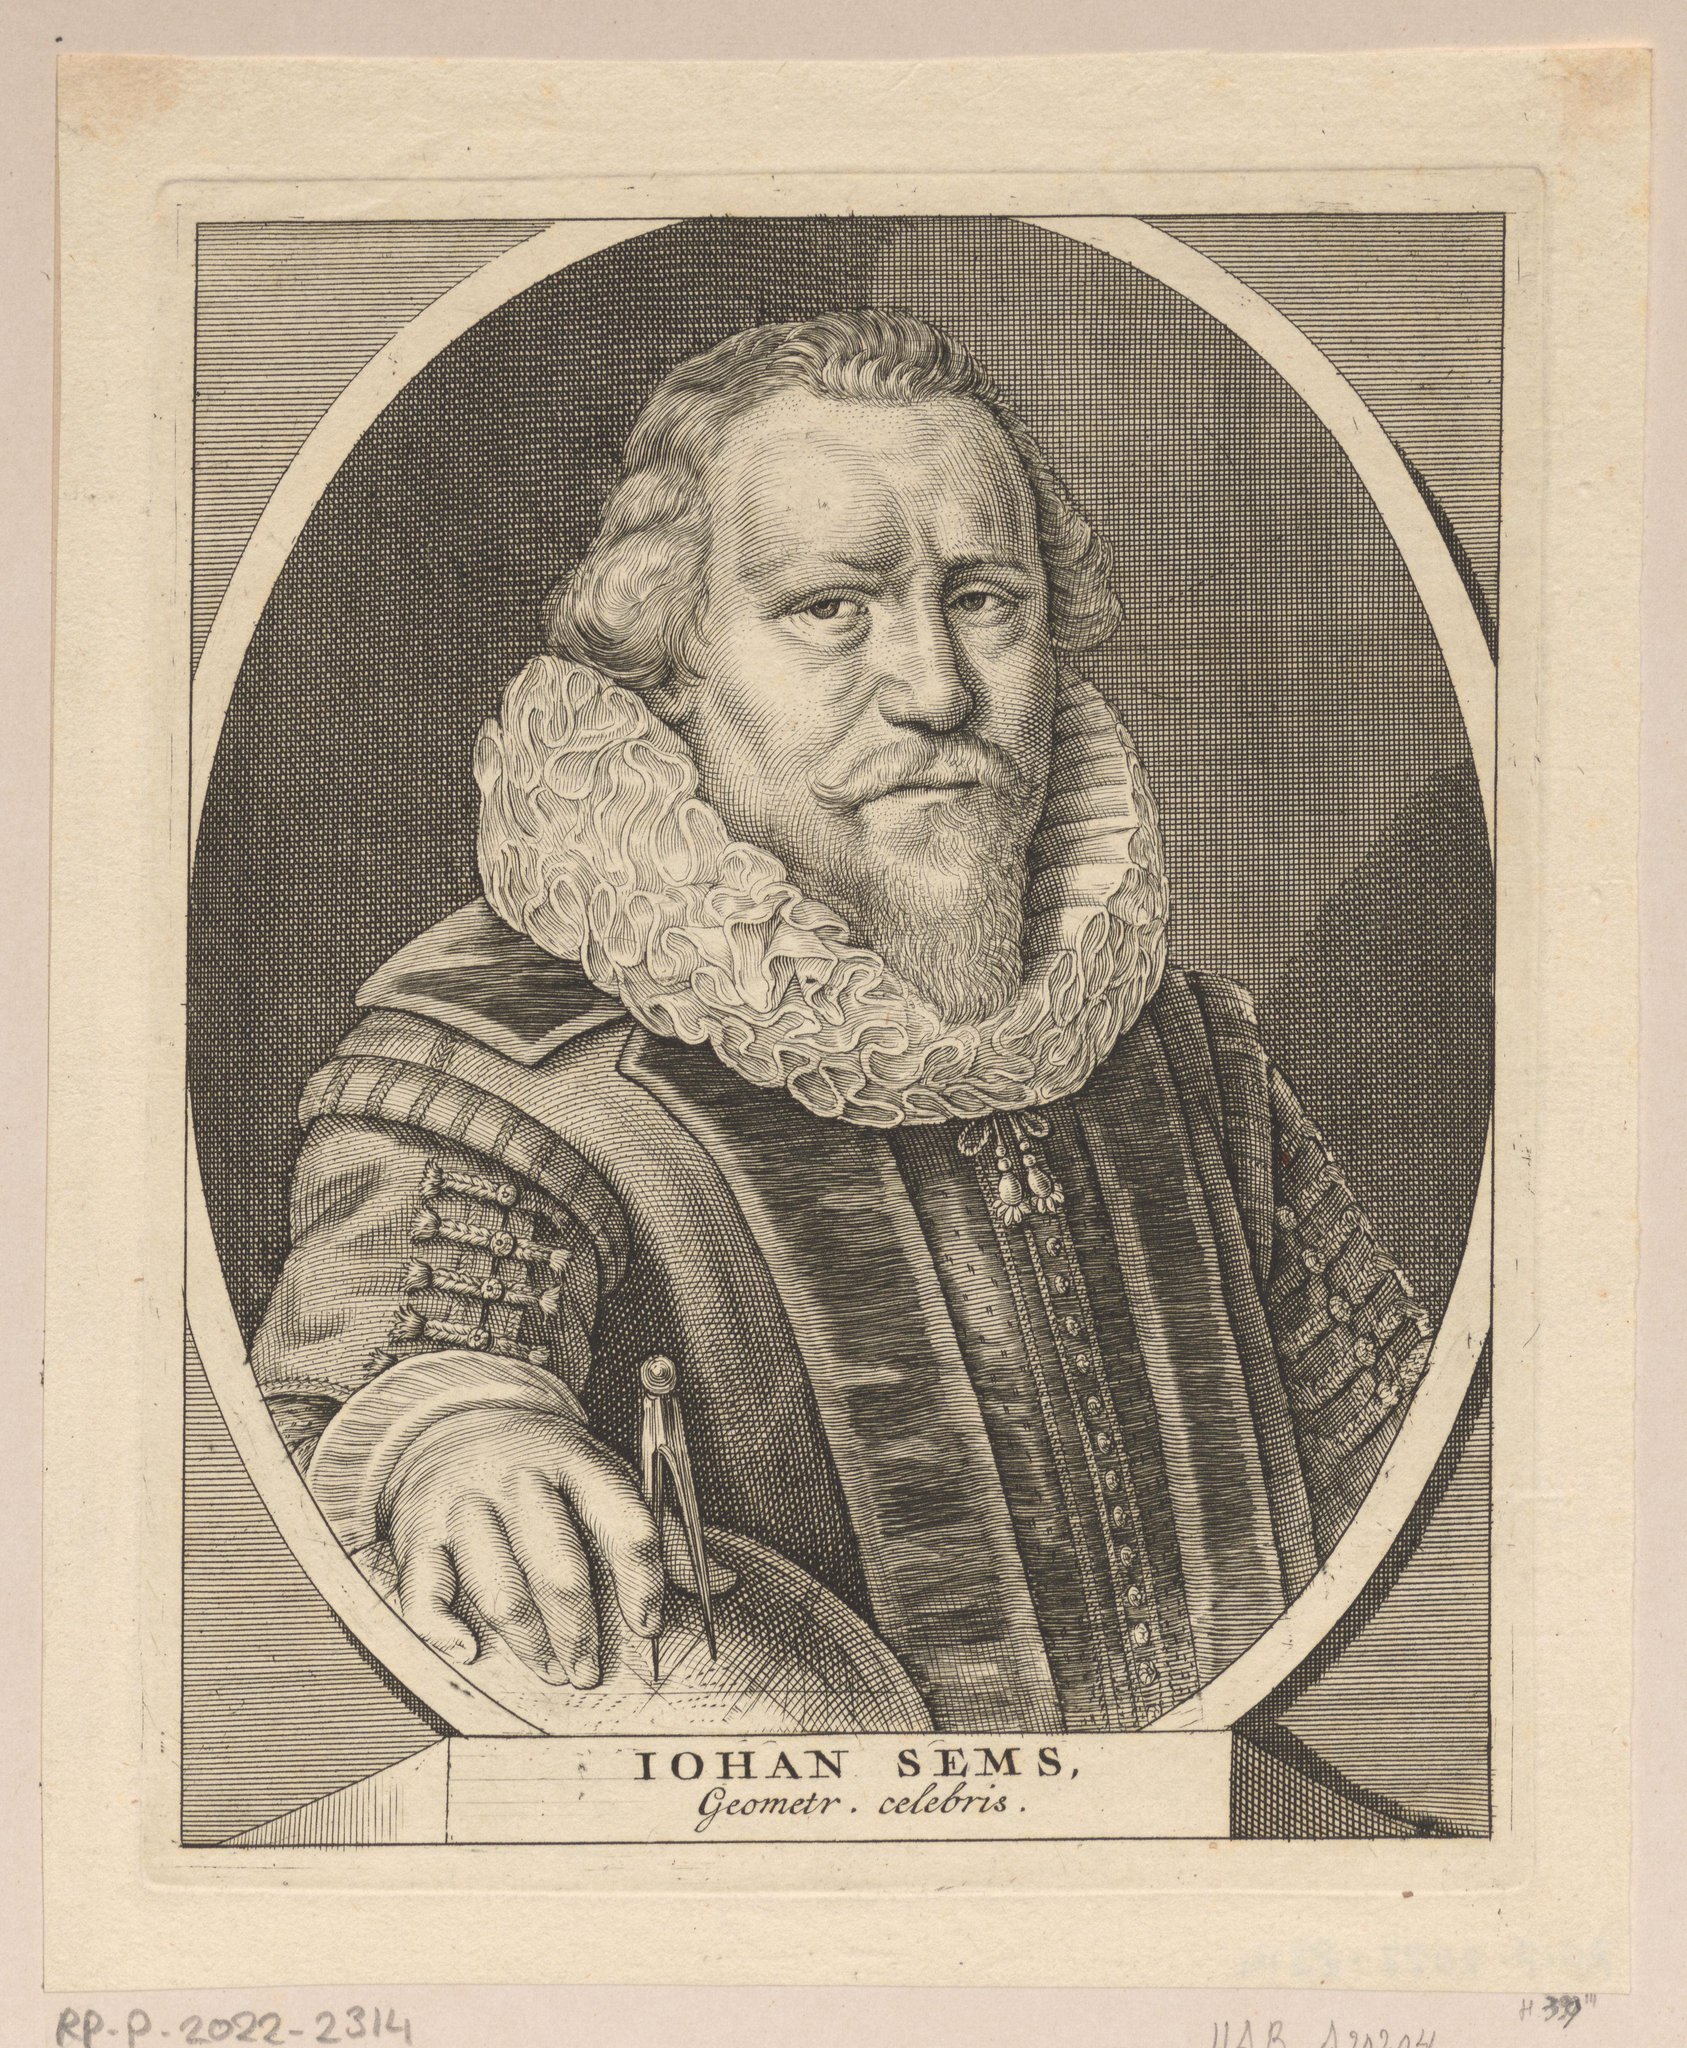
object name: print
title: Icones clarissimorum medicorum philosophorum liberales artes profitentium aliorumque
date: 1623-1625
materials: paper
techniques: engraving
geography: leiden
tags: johan sems, land registry, historical persons, mathematics (+ portrait of scholar, scientist)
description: Met eenregelig onderschrift in het Latijn.